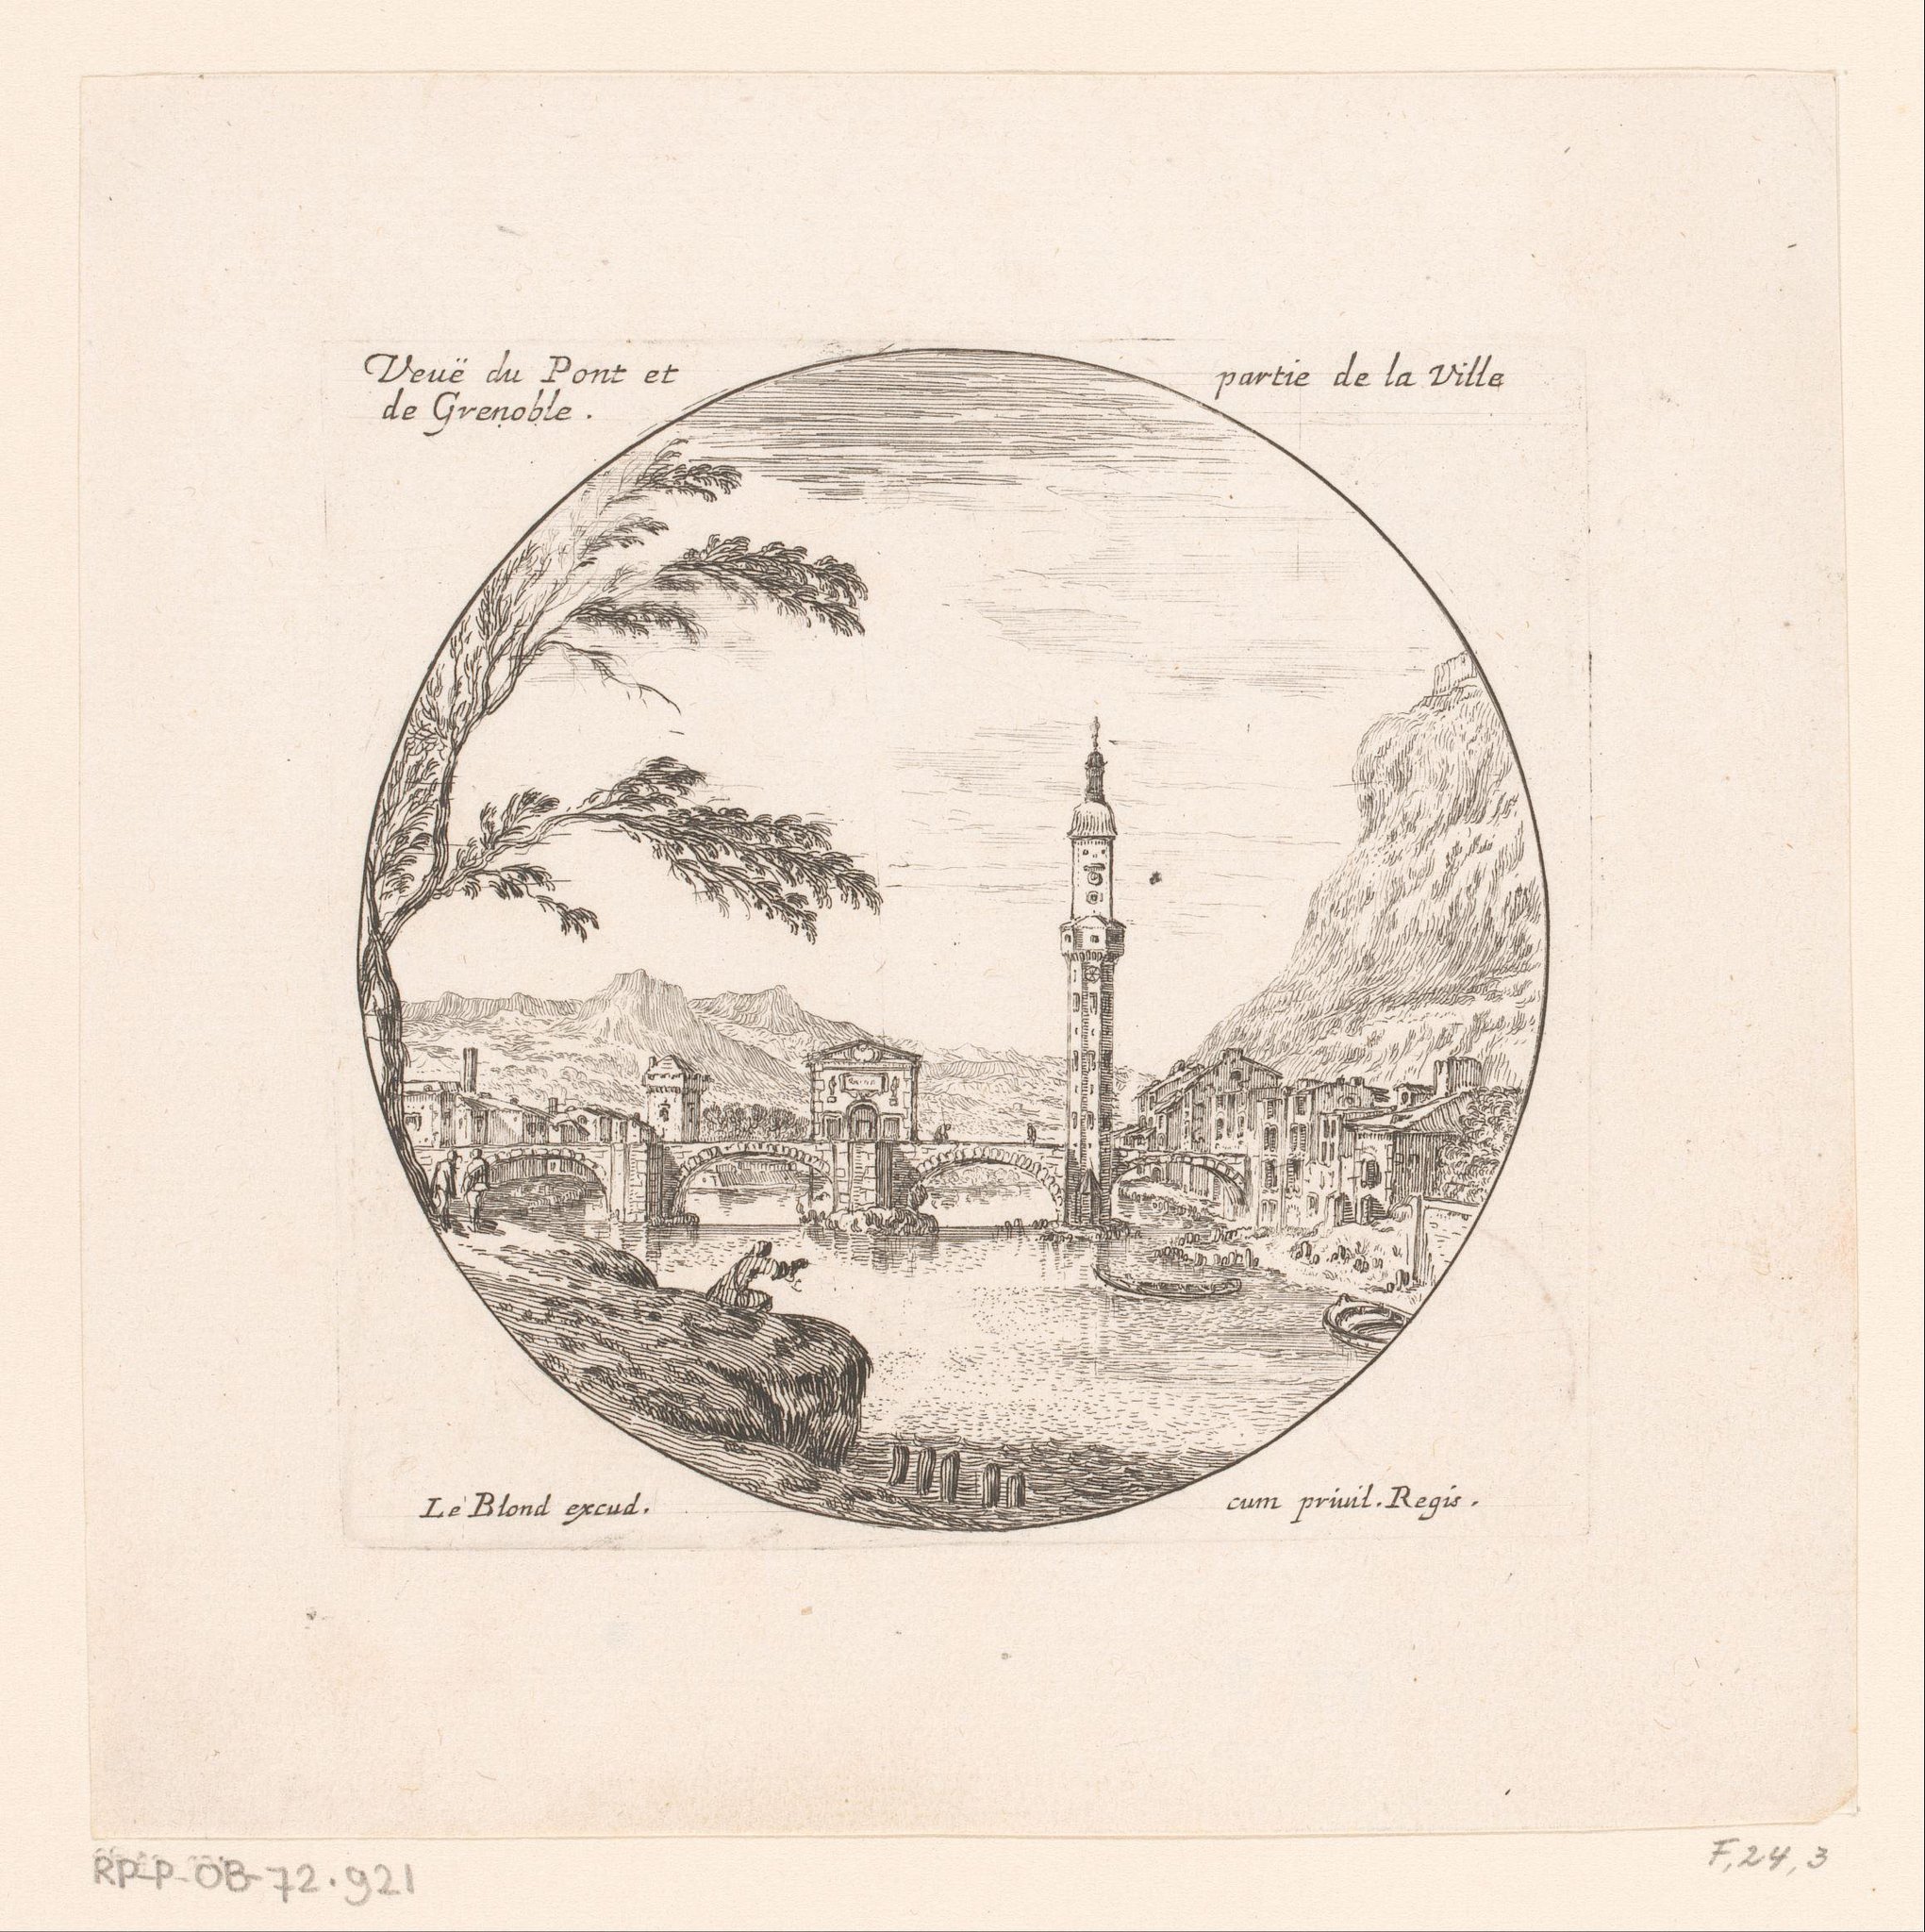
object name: print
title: Gezicht op brug in Grenoble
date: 1645-1691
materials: paper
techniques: etching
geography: france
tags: bridge in city across river, canal, etc.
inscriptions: collector's mark: Lugt 240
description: Prent maakt deel uit van een ongenummerde serie van zes prenten.